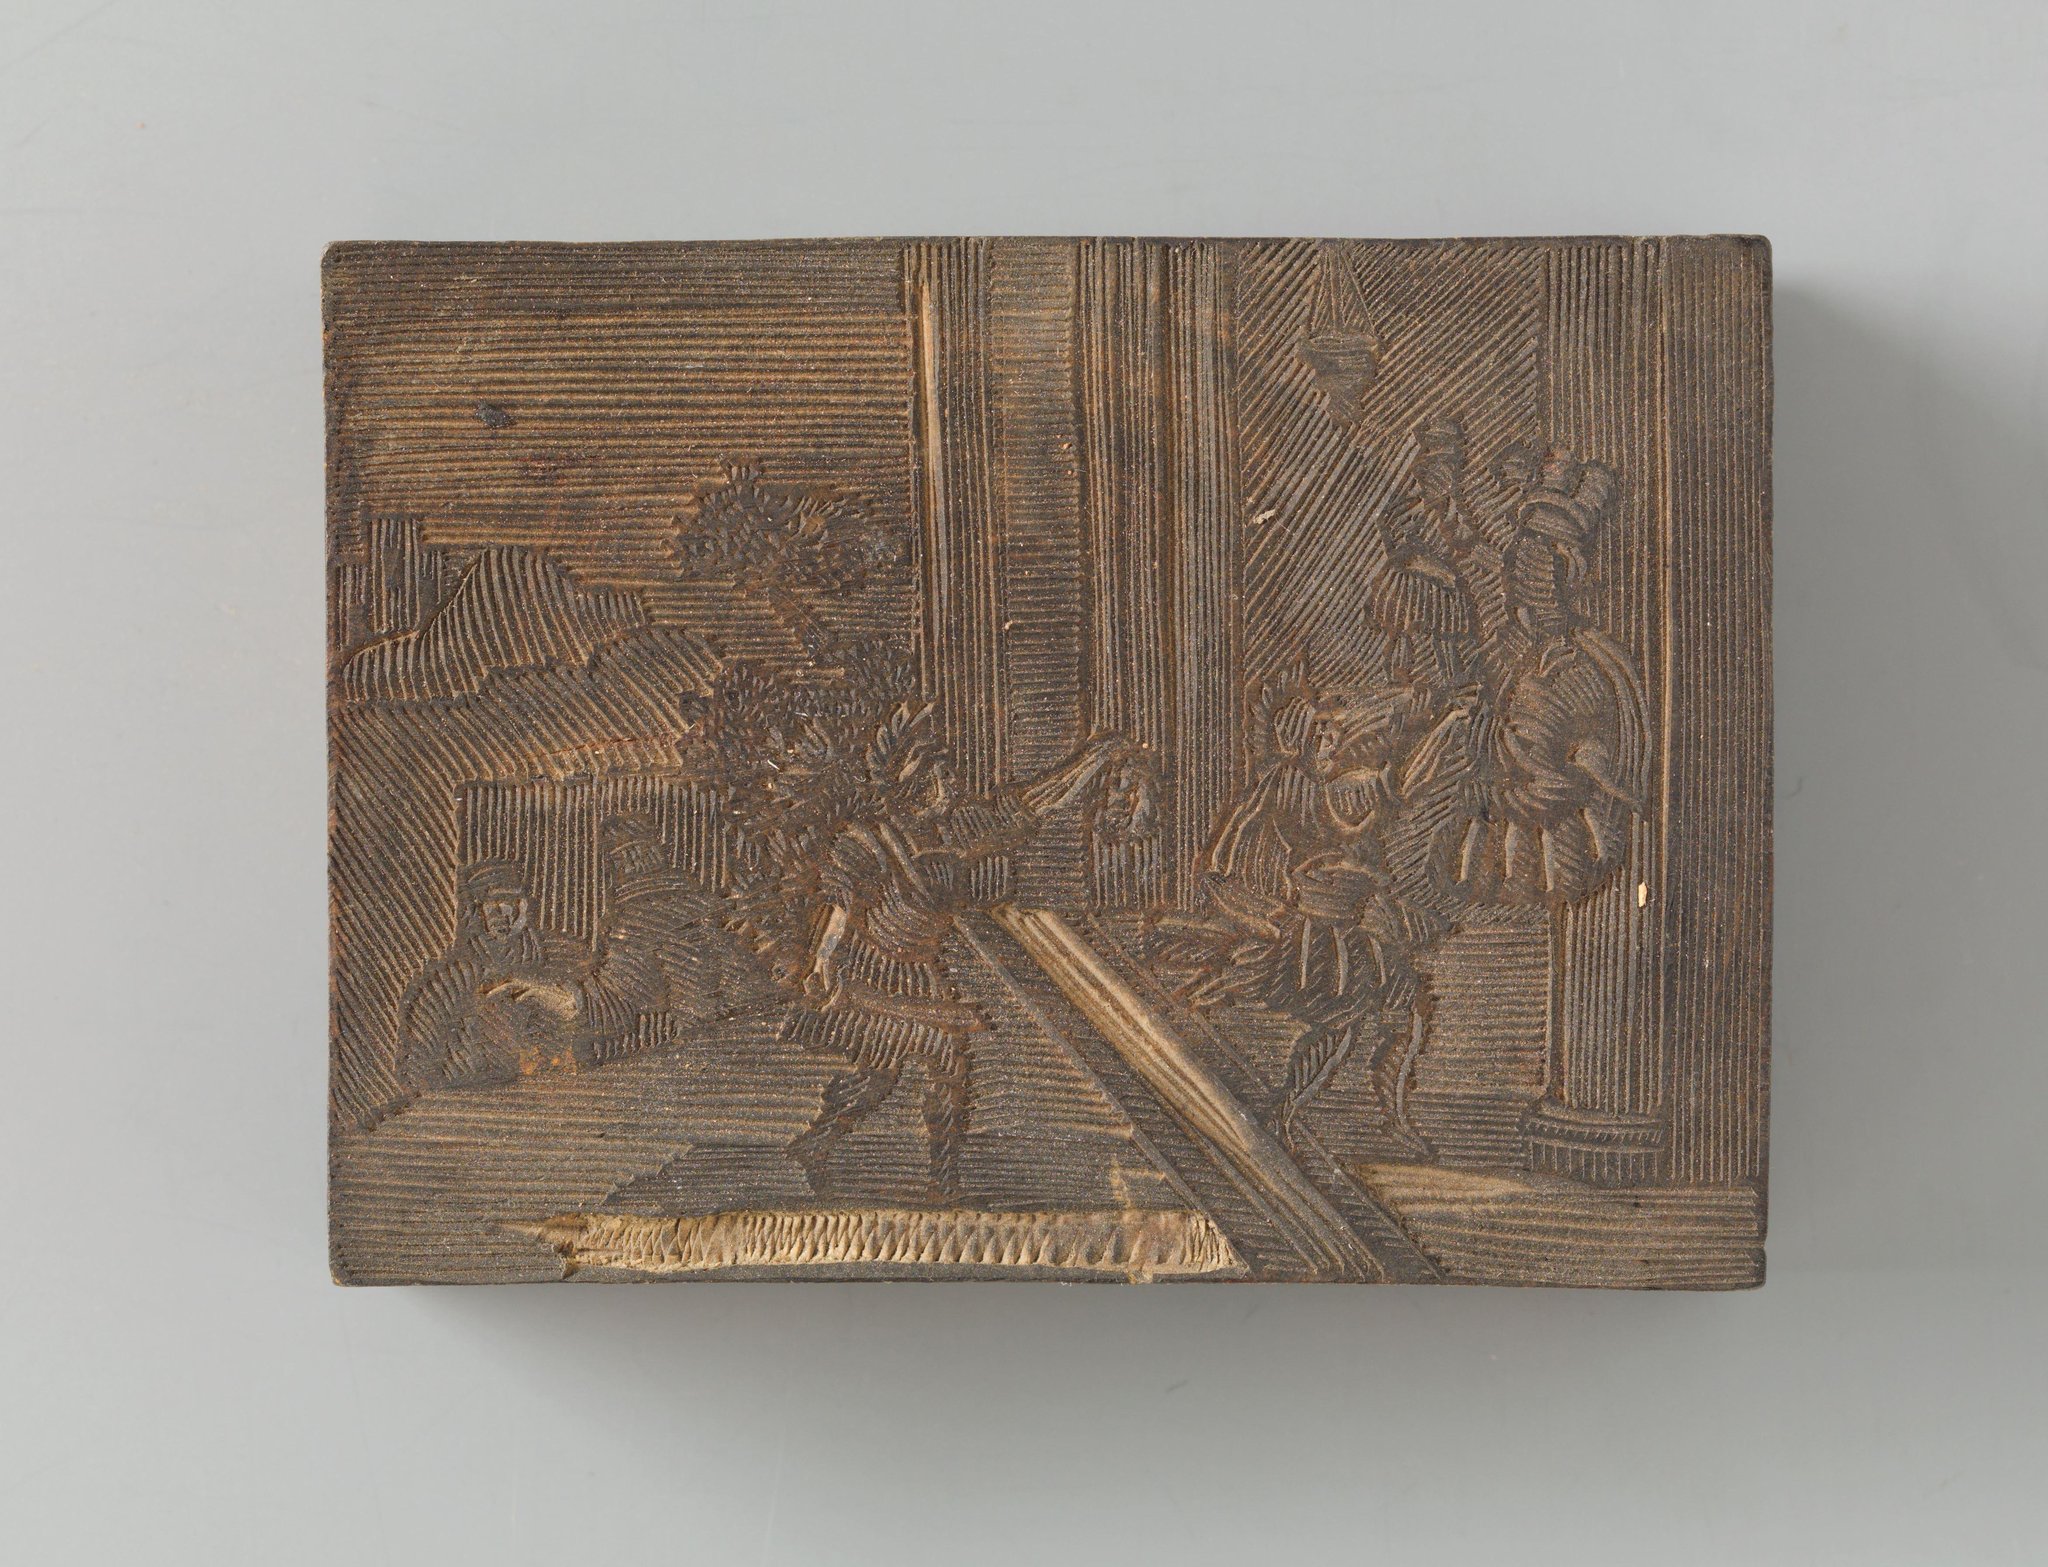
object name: wood block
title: Bijbel-illustraties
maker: Anonymous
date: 1550-1699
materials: wood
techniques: woodcut